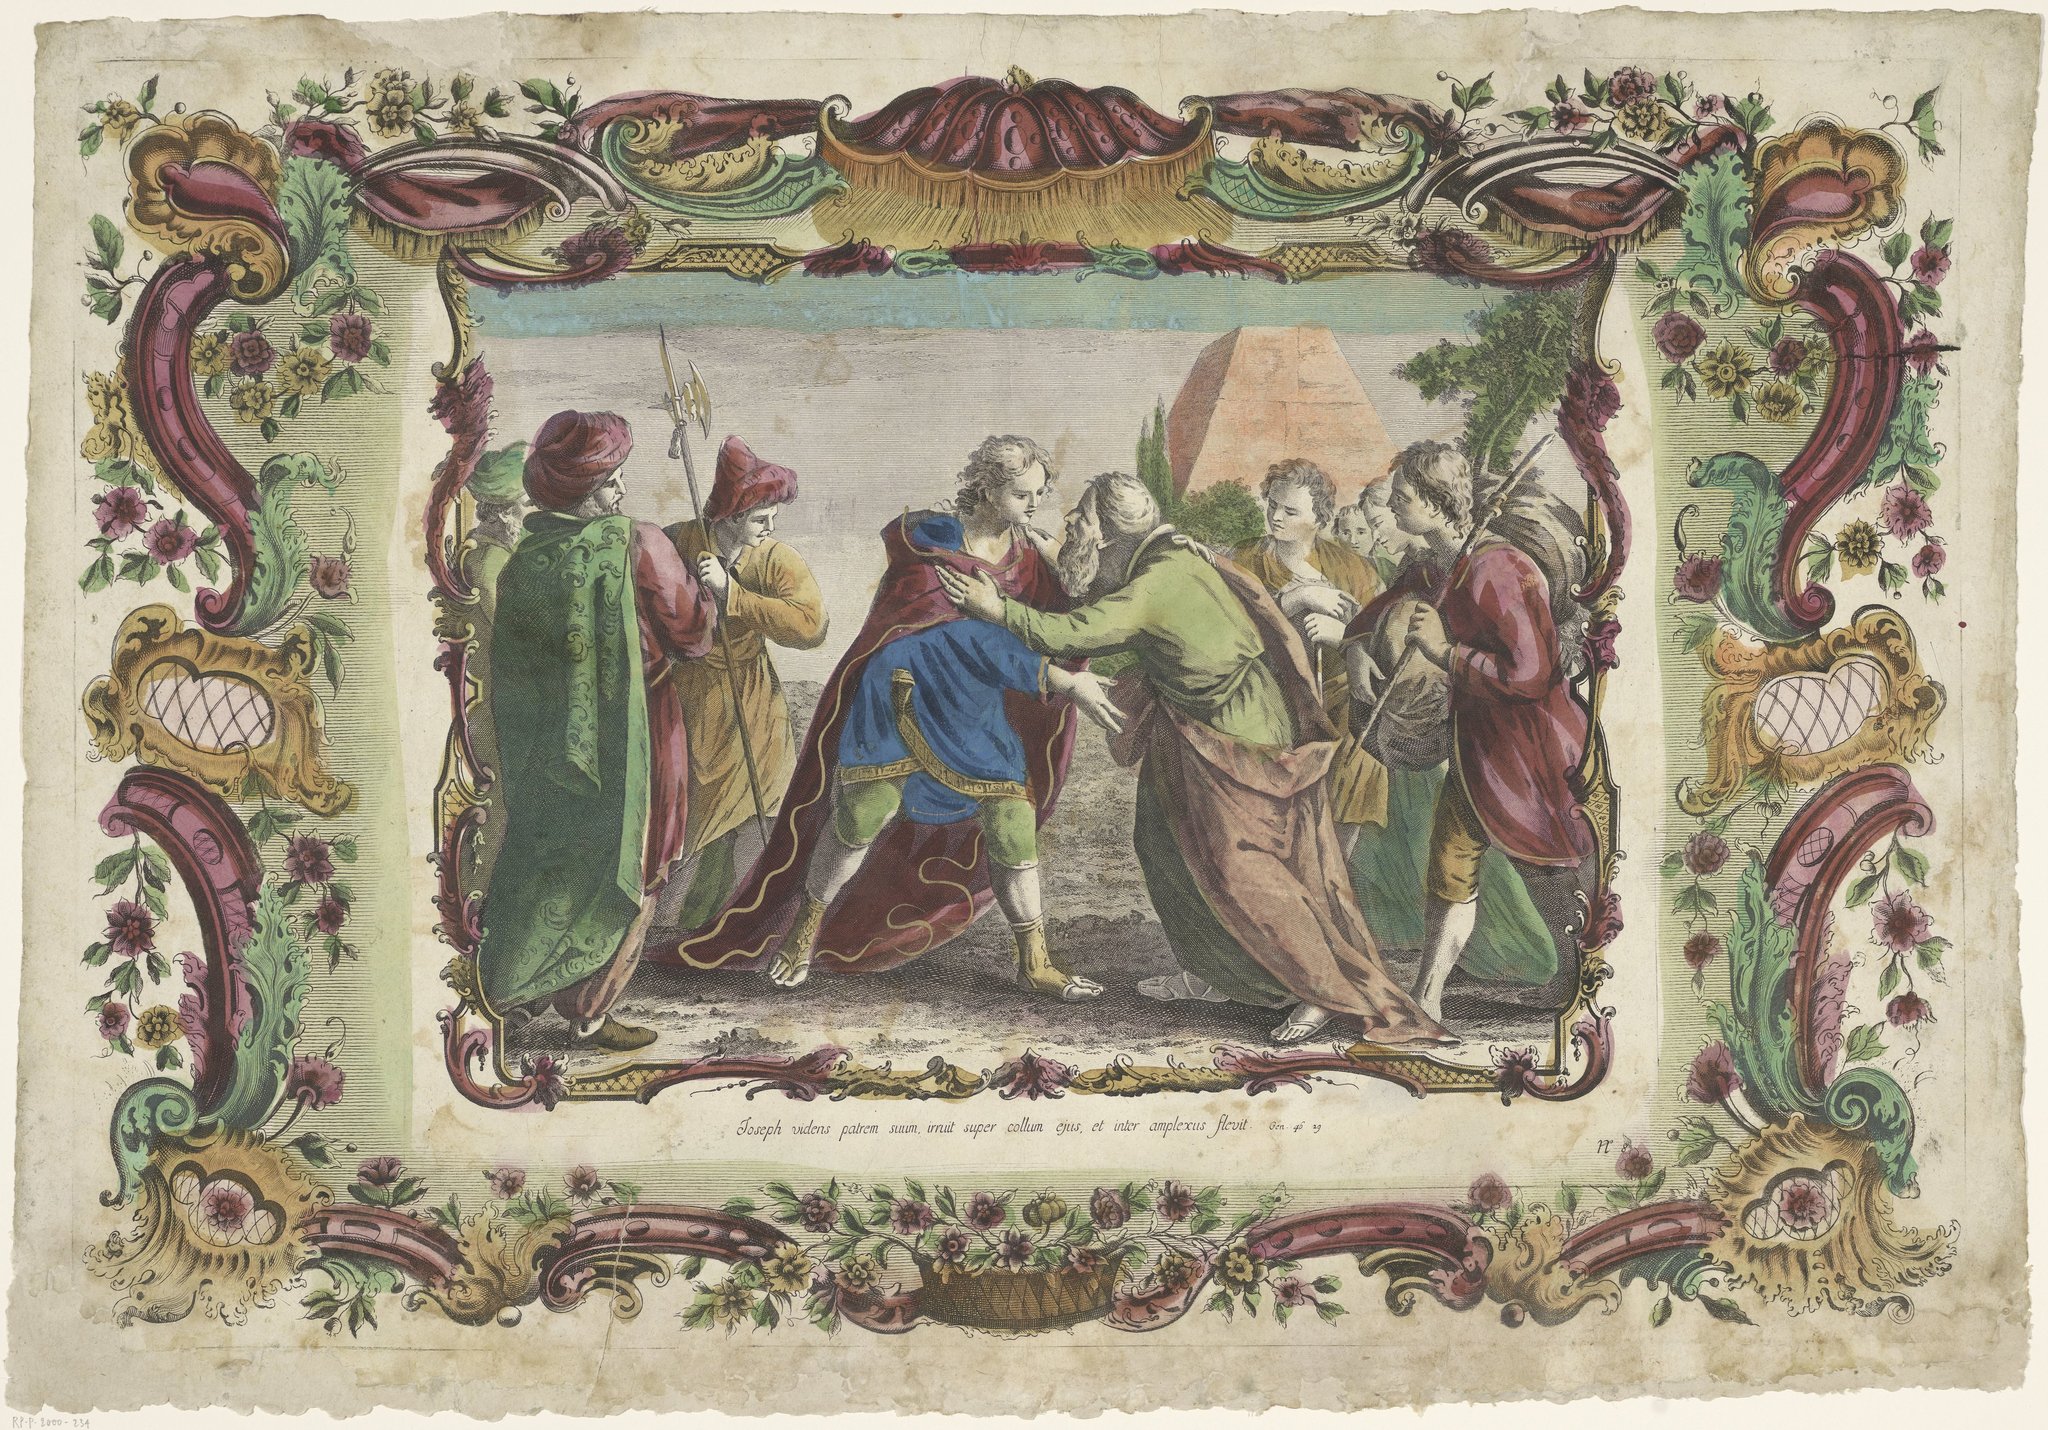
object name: print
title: Jozef ontmoet zijn vader in Goshen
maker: giovanni volpato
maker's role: ceramicist, print maker, printer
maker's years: 1735-1803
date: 1700-1799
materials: paper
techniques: colour, engraving, etching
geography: bassano del grappa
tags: the meeting of jacob and joseph in goshen, ornaments ~ art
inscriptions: collector's mark: Lugt 2228, collector's mark: Lugt 2760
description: De oude Jacob omhelst zijn zoon Jozef in een landschap met omstanders. Op de achtergrond een piramide. Verwijzing naar Bijbeltekst onder de voorstelling. De scène is gevat in een ornamentrand. Genummerd rechtsonder: No. 8.